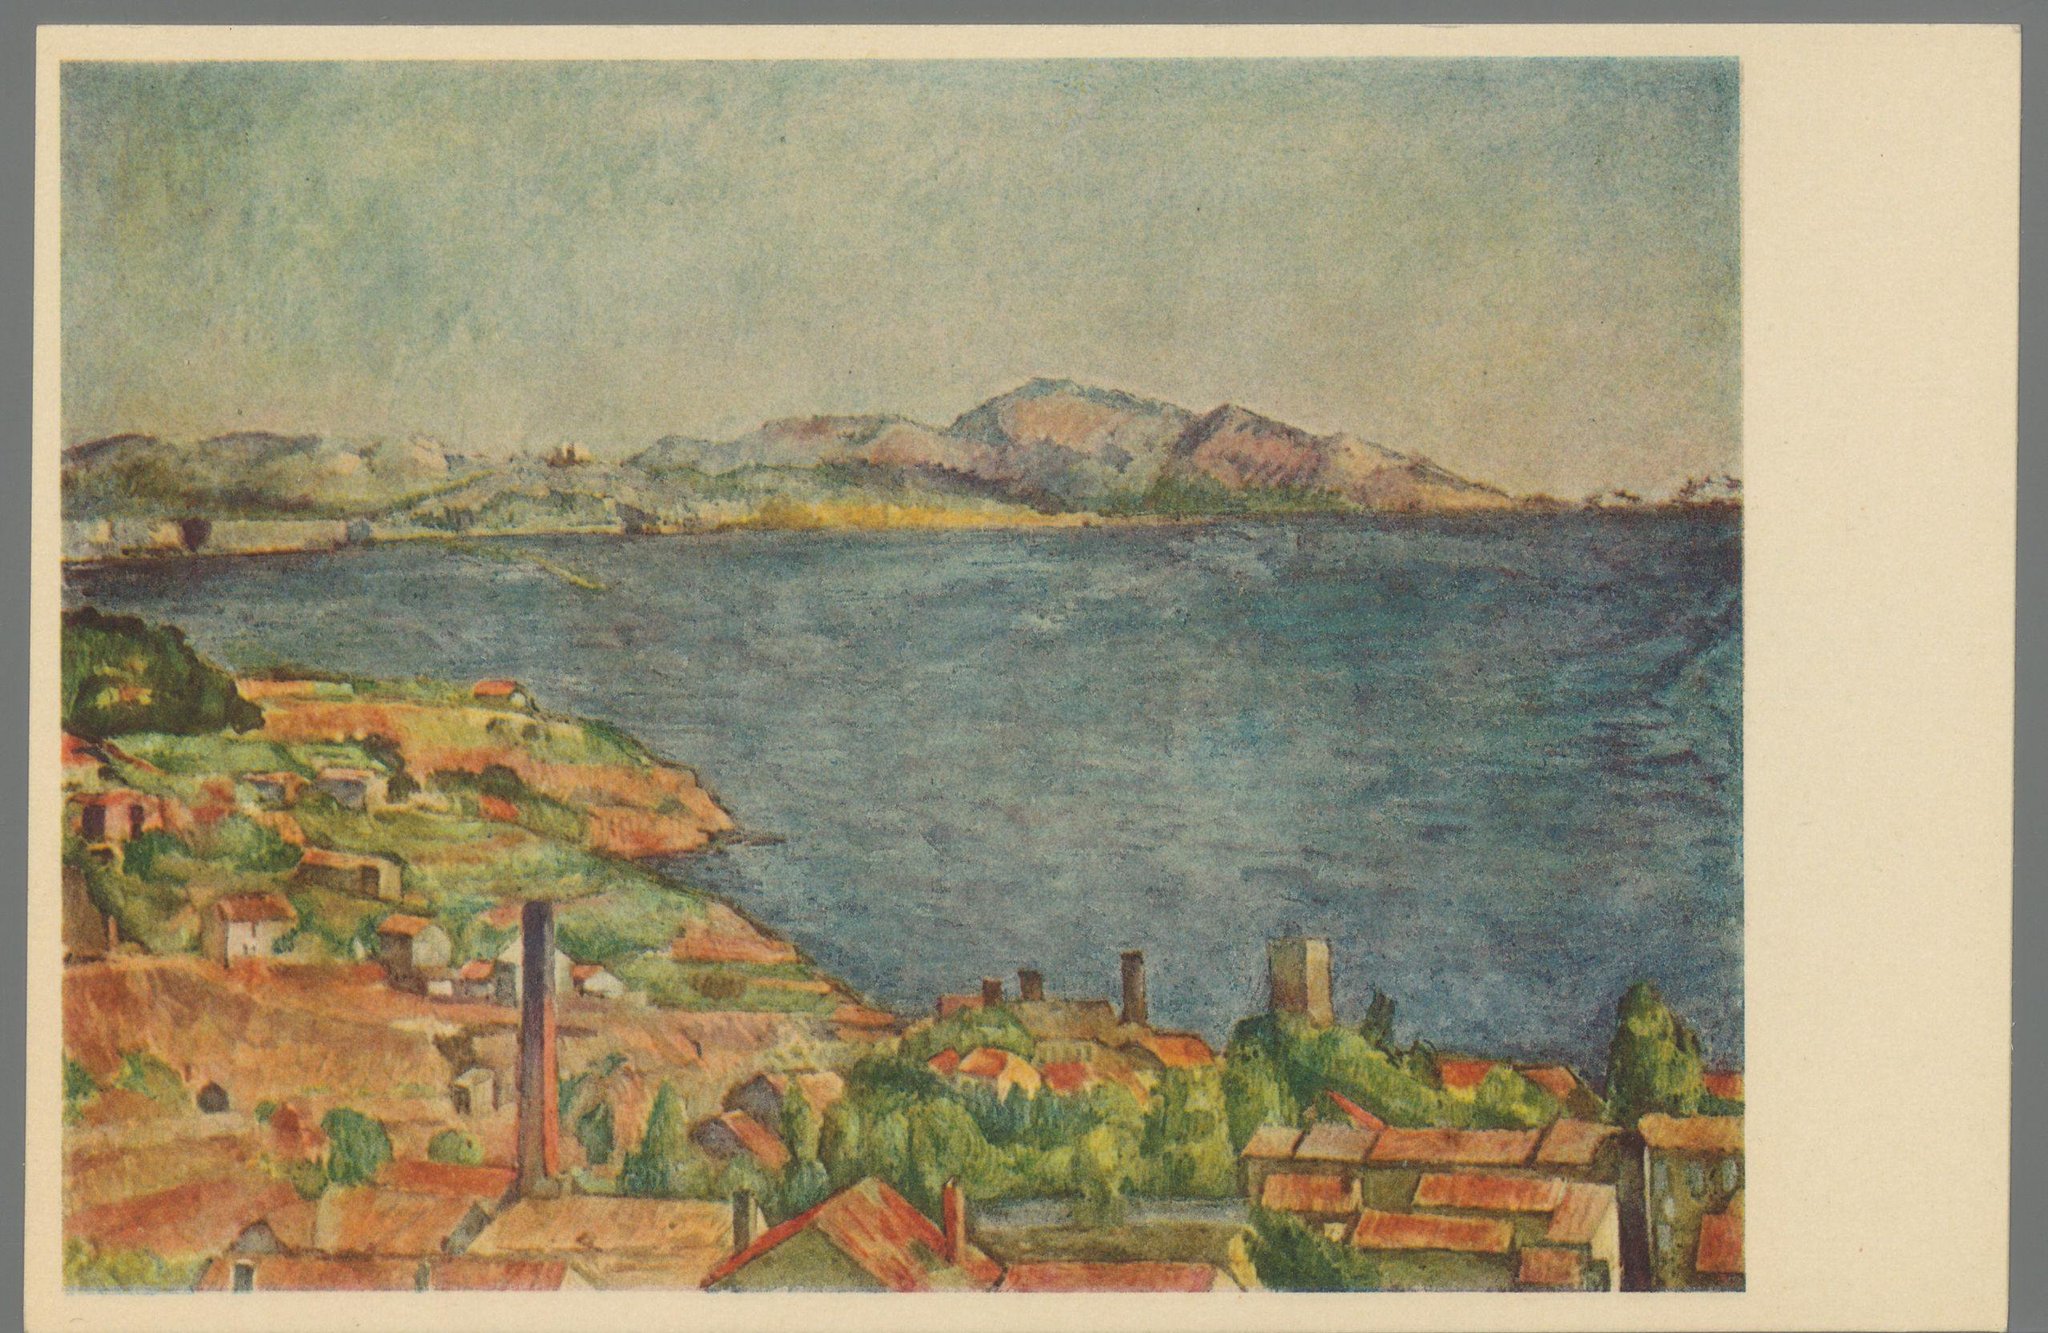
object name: reproduction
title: L'Estaque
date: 1929-1950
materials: cardboard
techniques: photograph, lithograph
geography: new york city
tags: sea (seascape), prospect of city, town panorama, silhouette of city